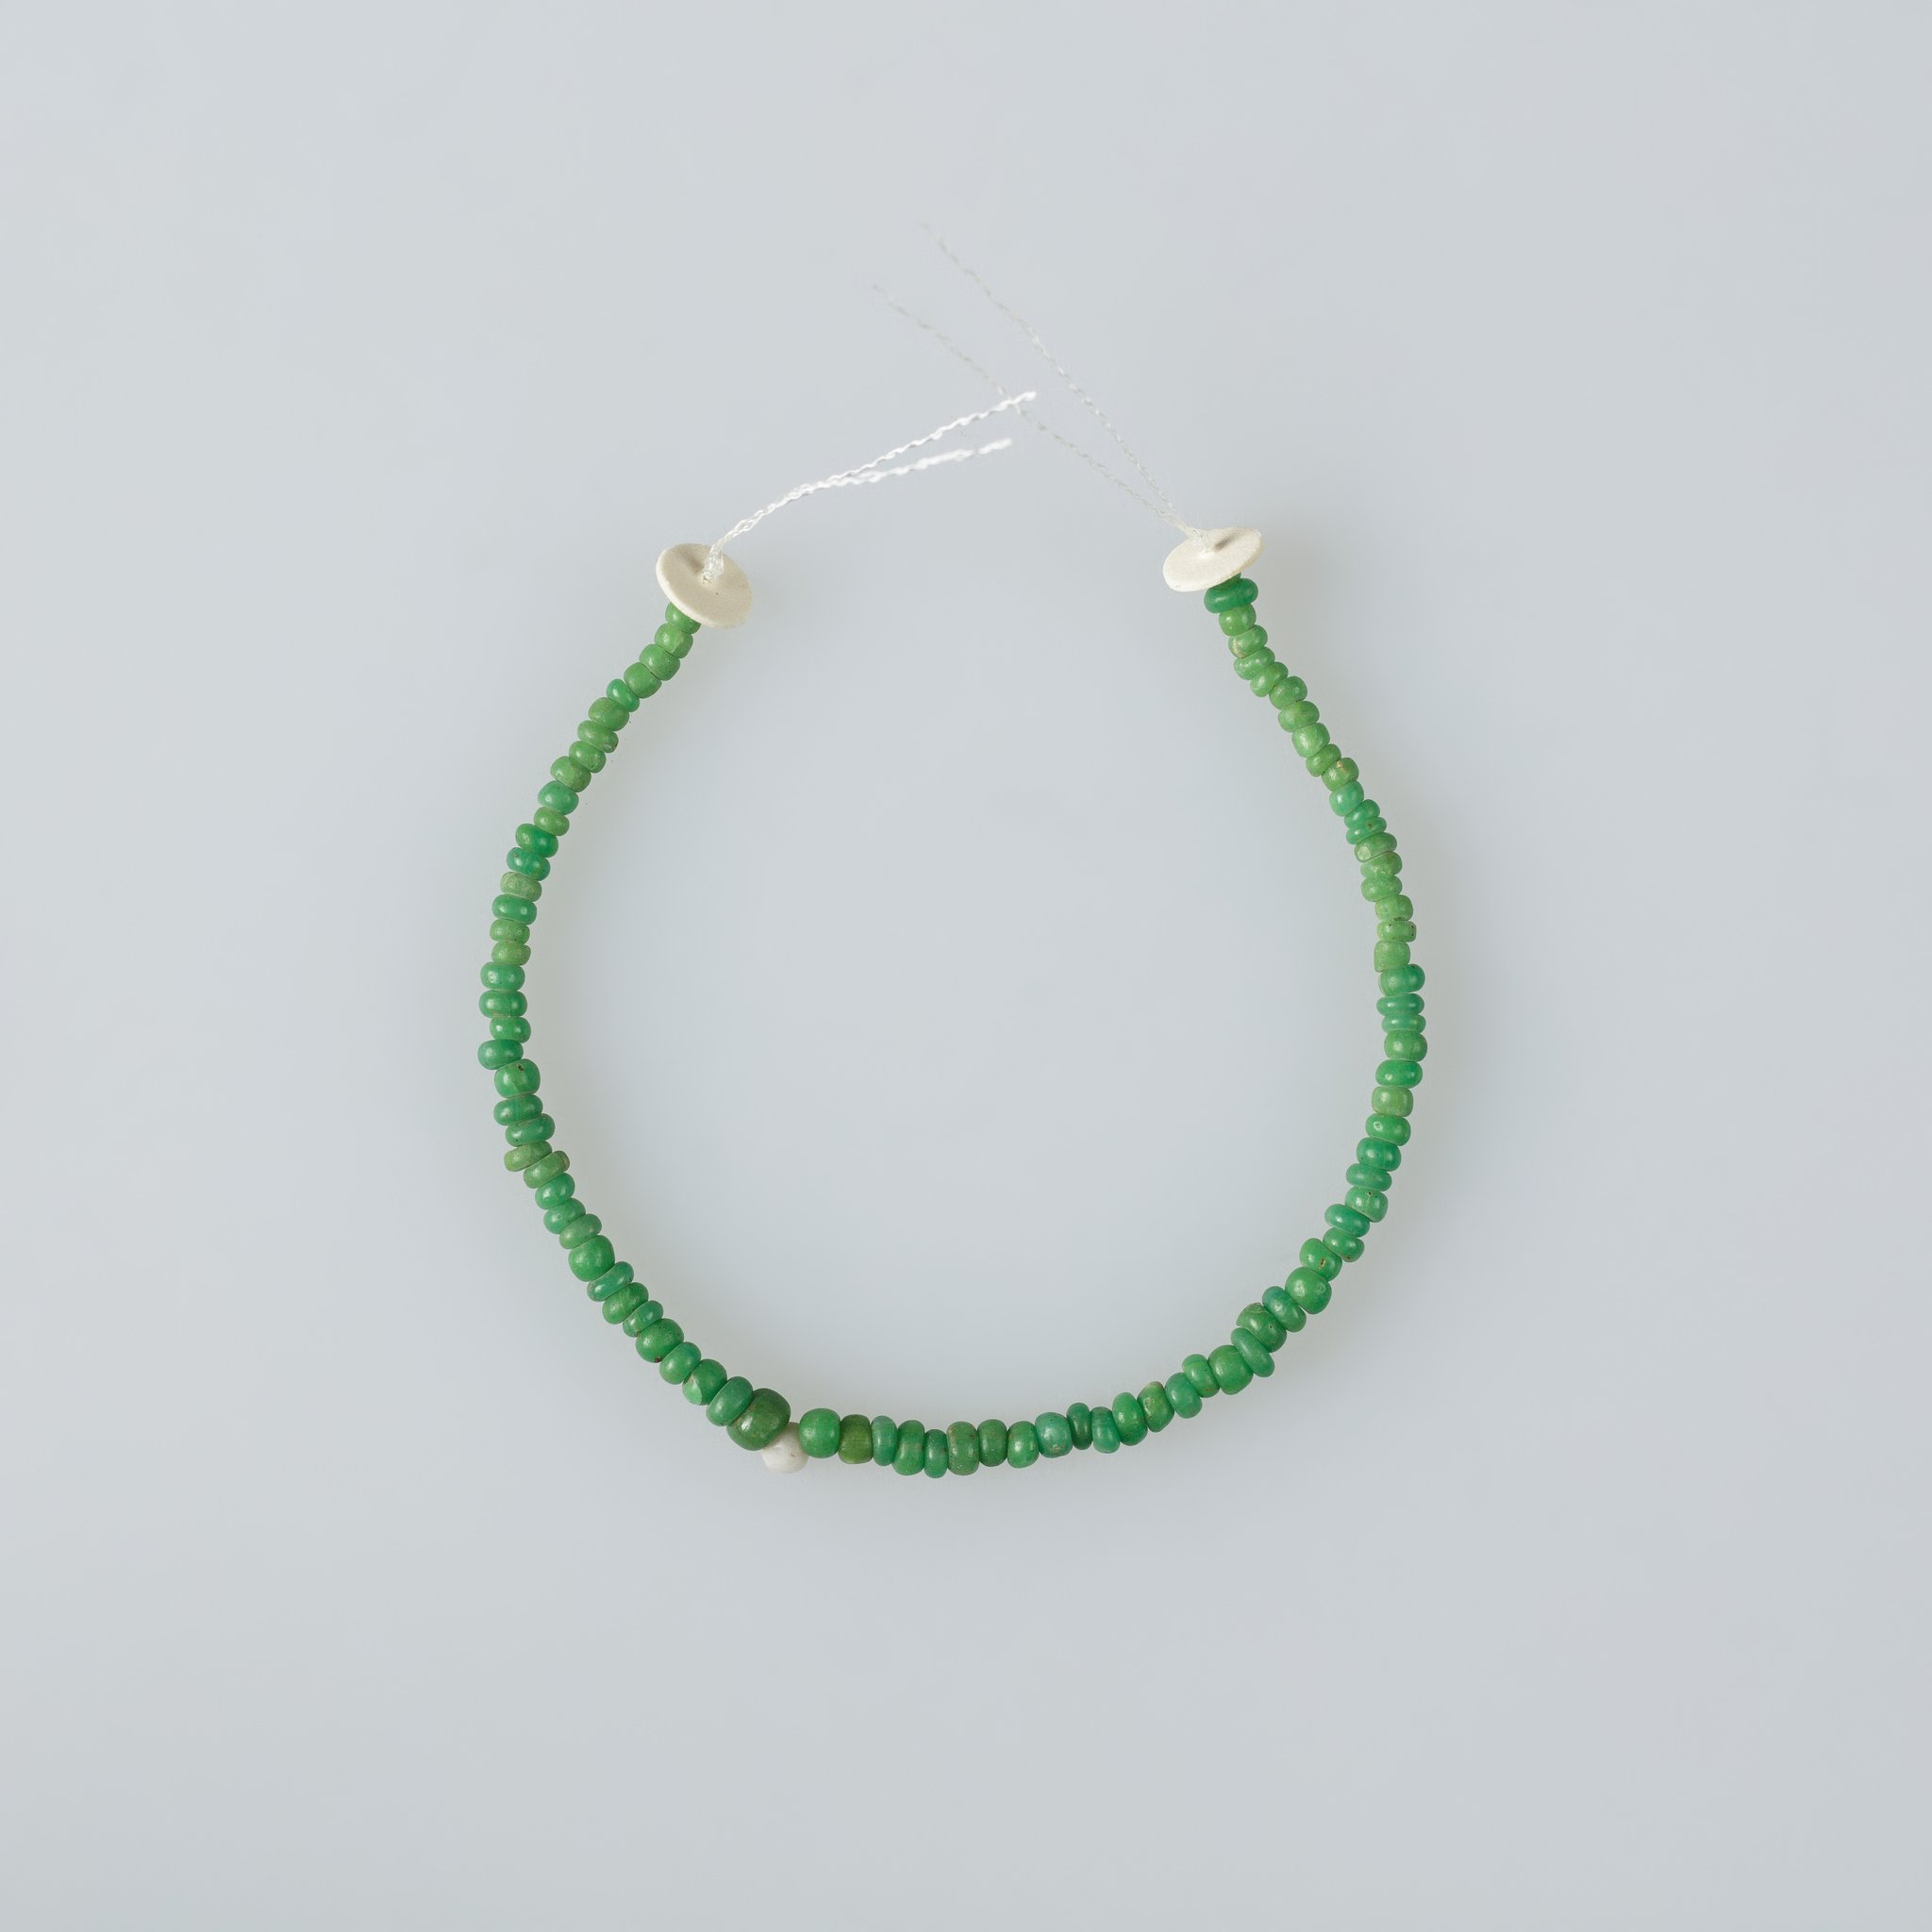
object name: bead, string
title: String of beads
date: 30 BCE-364 CE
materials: glass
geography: nubia